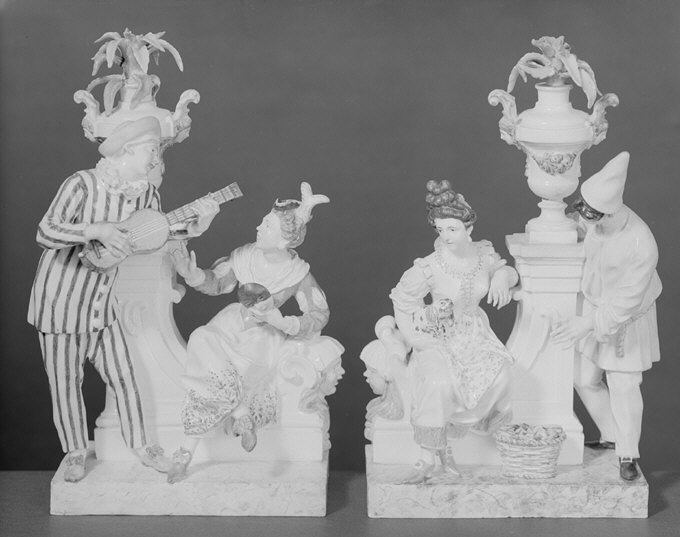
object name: group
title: Pair of Italian comedy actors (Mezzetin and Elizabeth (?))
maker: real fabrica de buen retiro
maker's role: factory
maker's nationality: spanish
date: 1770-1780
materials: soft paste porcelain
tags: musical instruments,men,women,actors